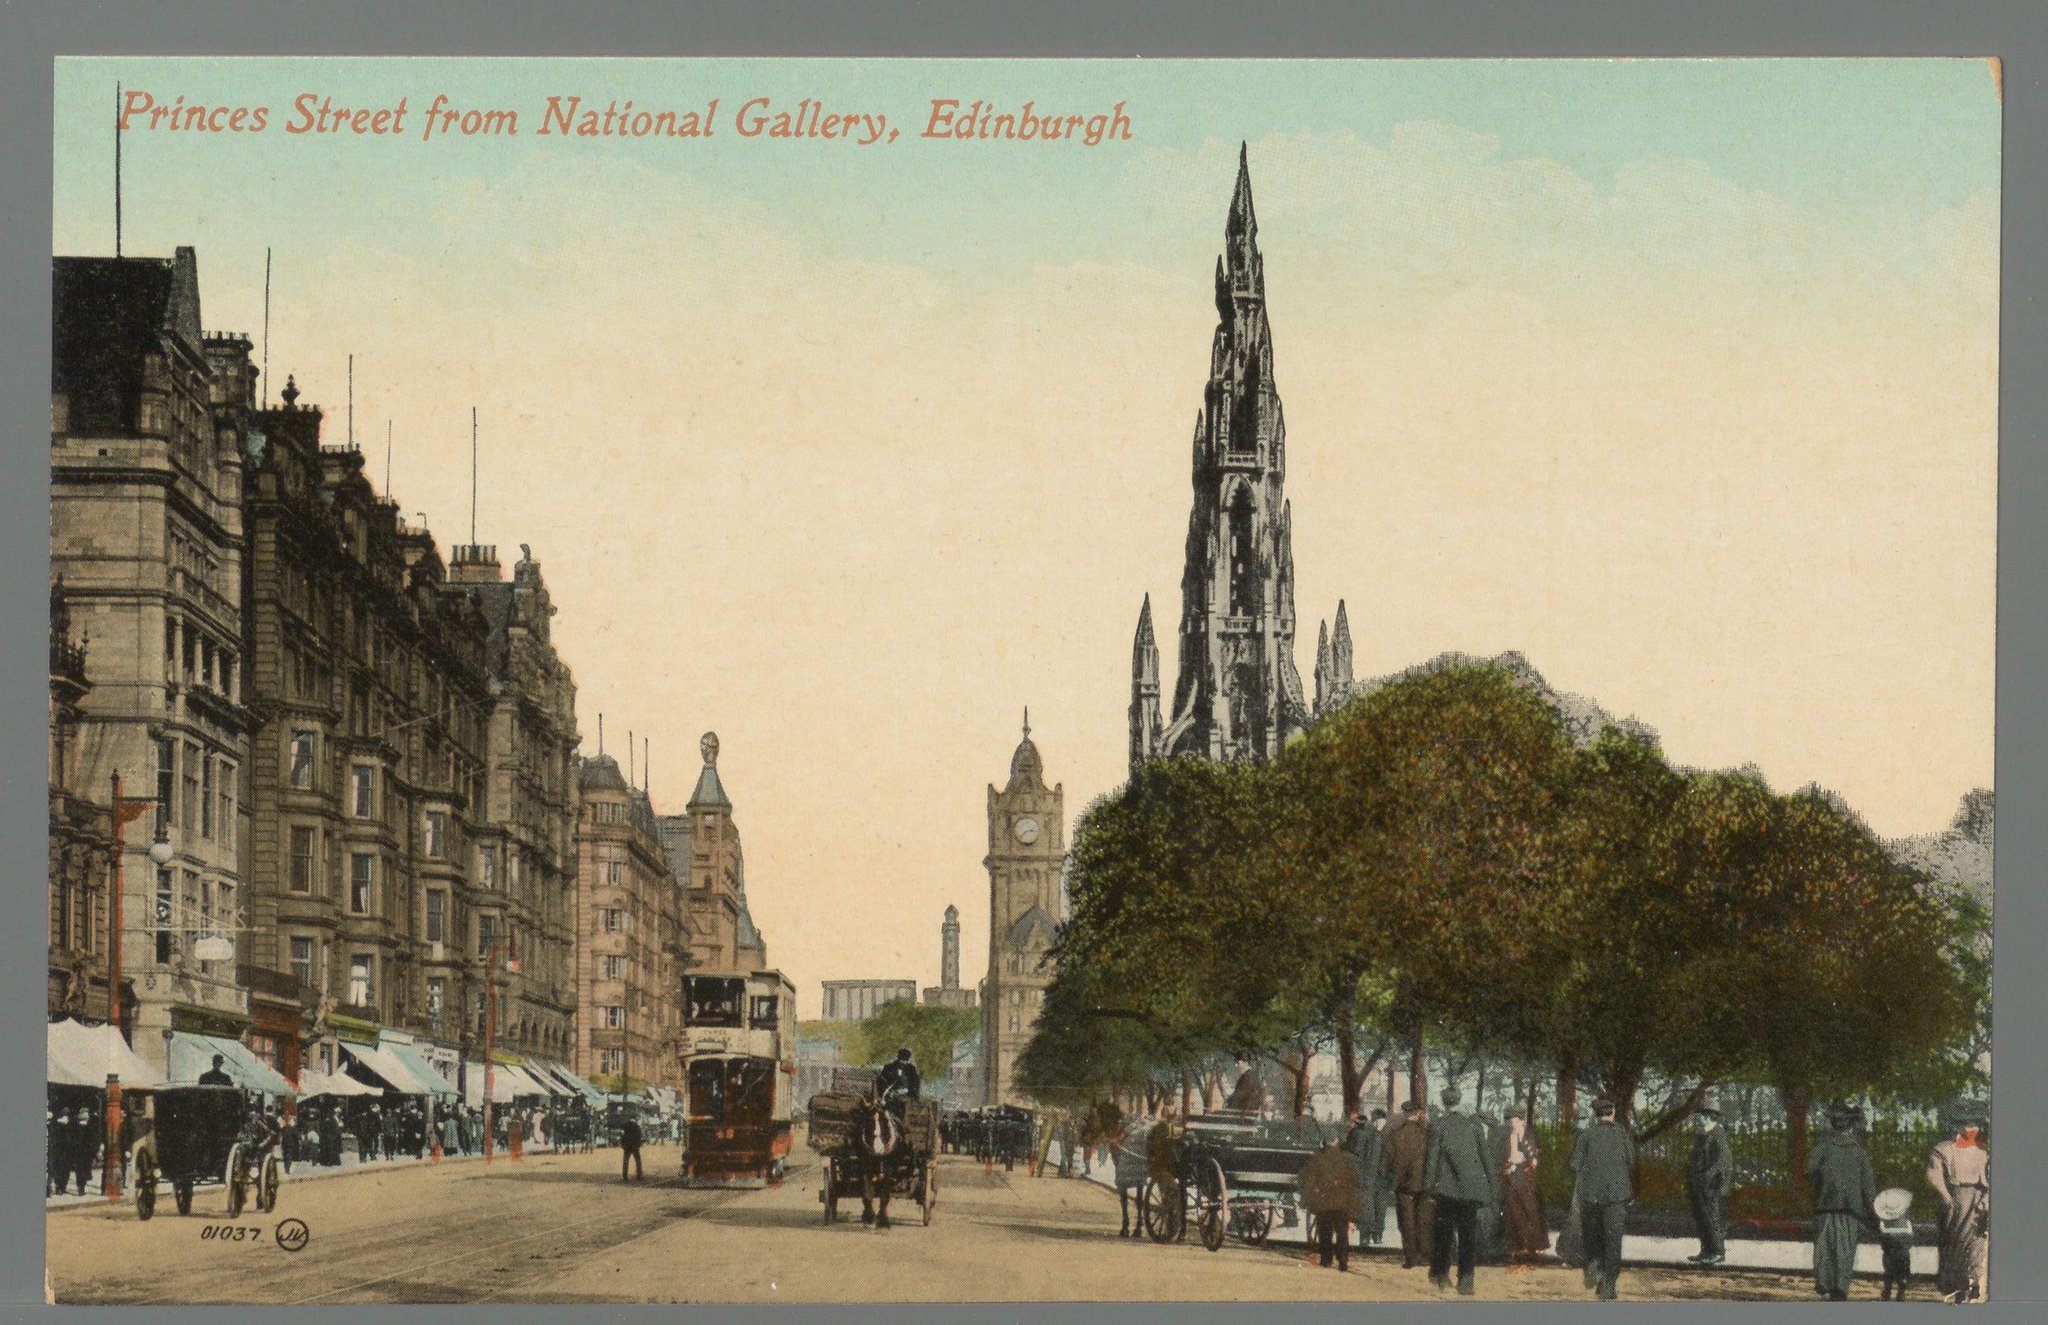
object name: ansichtkaart, prentbriefkaart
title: Princes Street from National Gallery, Edinburgh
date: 1902-1930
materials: cardboard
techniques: lithograph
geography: dundee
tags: monument, statue, street